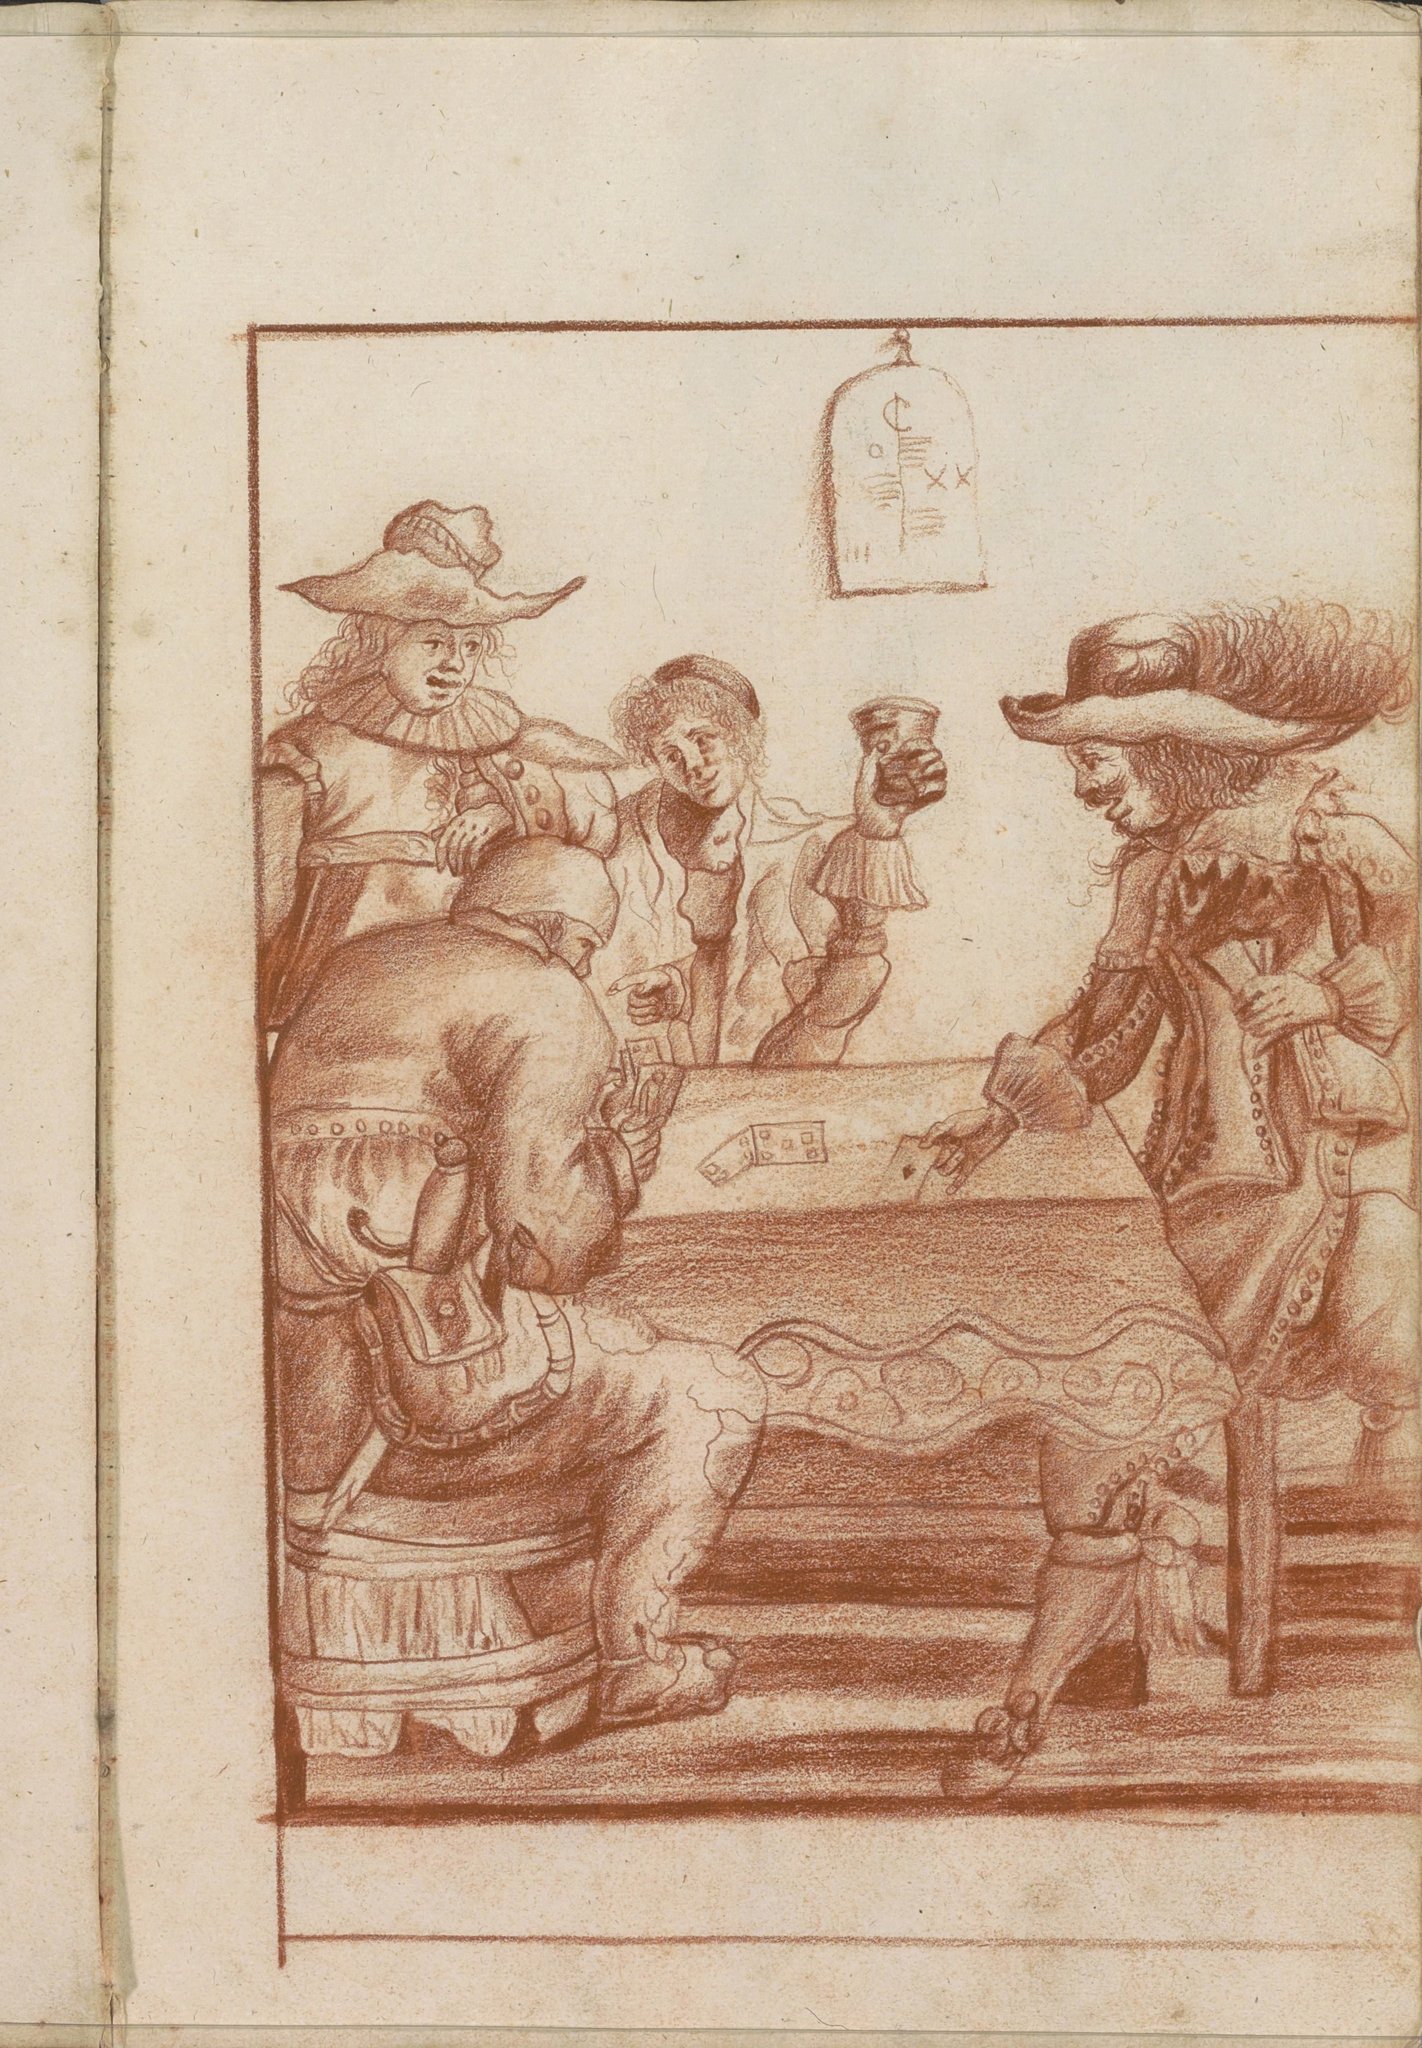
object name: sketchbook leaf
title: Kaartspelers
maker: hendrick van beaumont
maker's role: draughtsman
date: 1696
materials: chalk, paper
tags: playing-cards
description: Vier figuren hebben zich om een tafel geschaard. Twee spelen en twee bekijken een kaartspel. Een van hen, een vrouw, houdt een kroes in de hand. Blad 18 recto uit een schetsboek met 91 bladen.